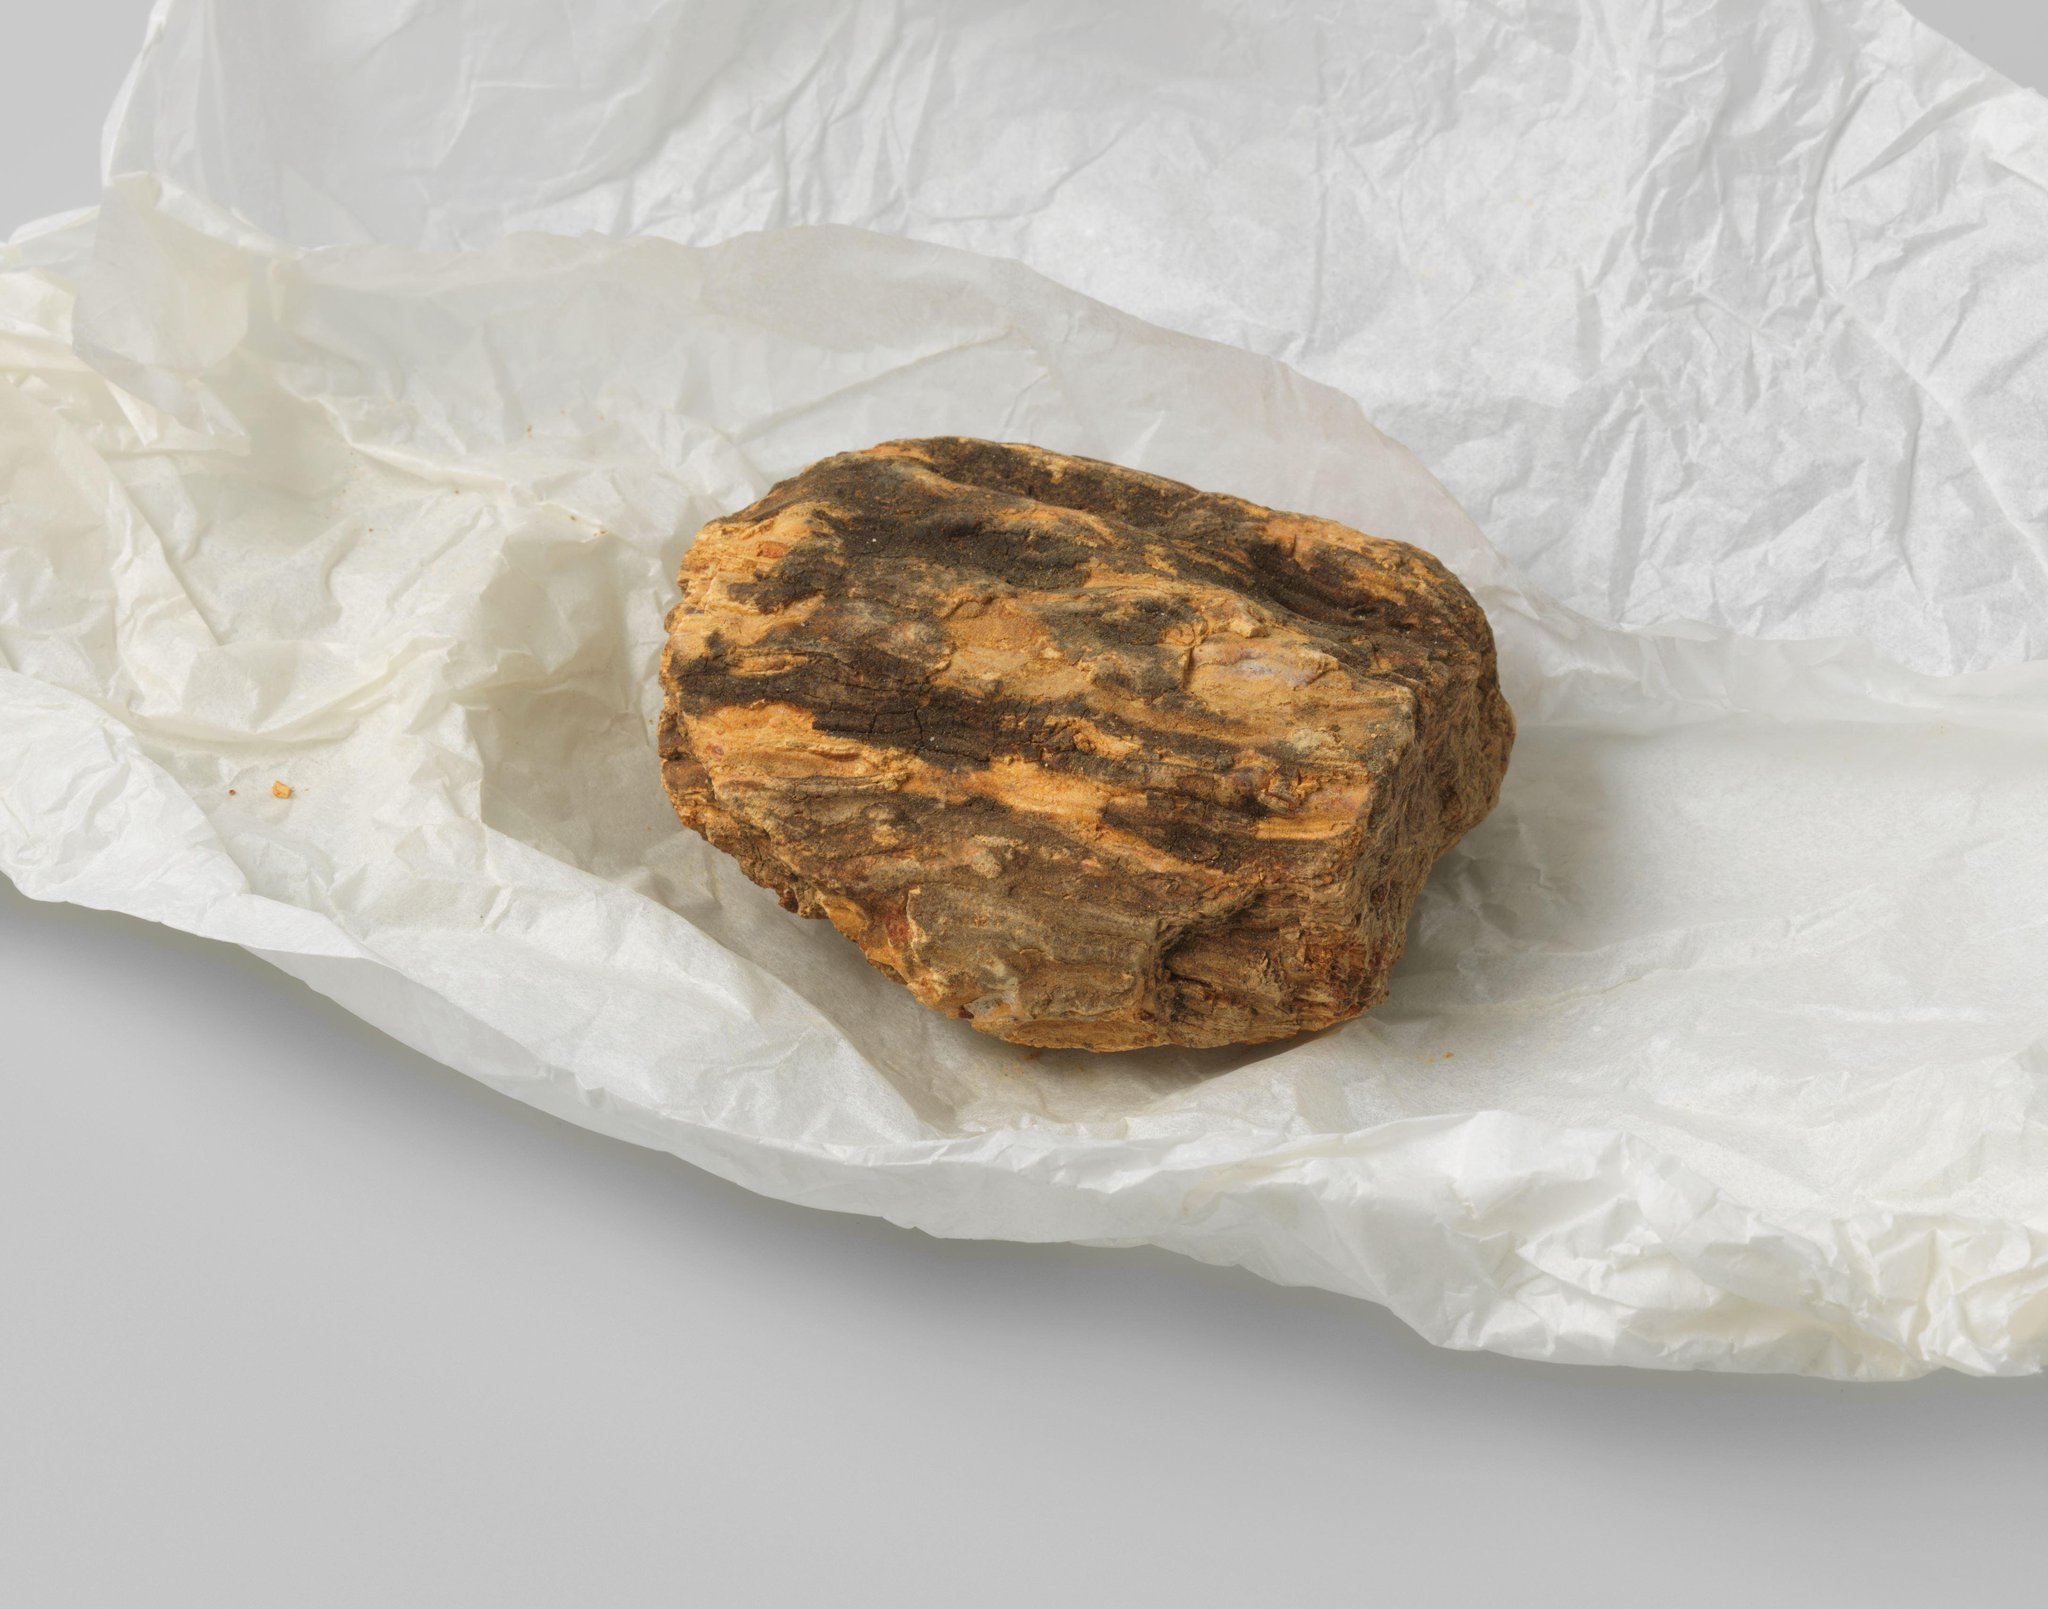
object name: artifact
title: Brok uit V.O.C.-schip de 'Witte Leeuw'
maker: Anonymous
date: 1613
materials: pigment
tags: verenigde oostindische compagnie, sint-helena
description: Brok uit V.O.C.-schip de 'Witte Leeuw', loodwit, grondstof voor verf.